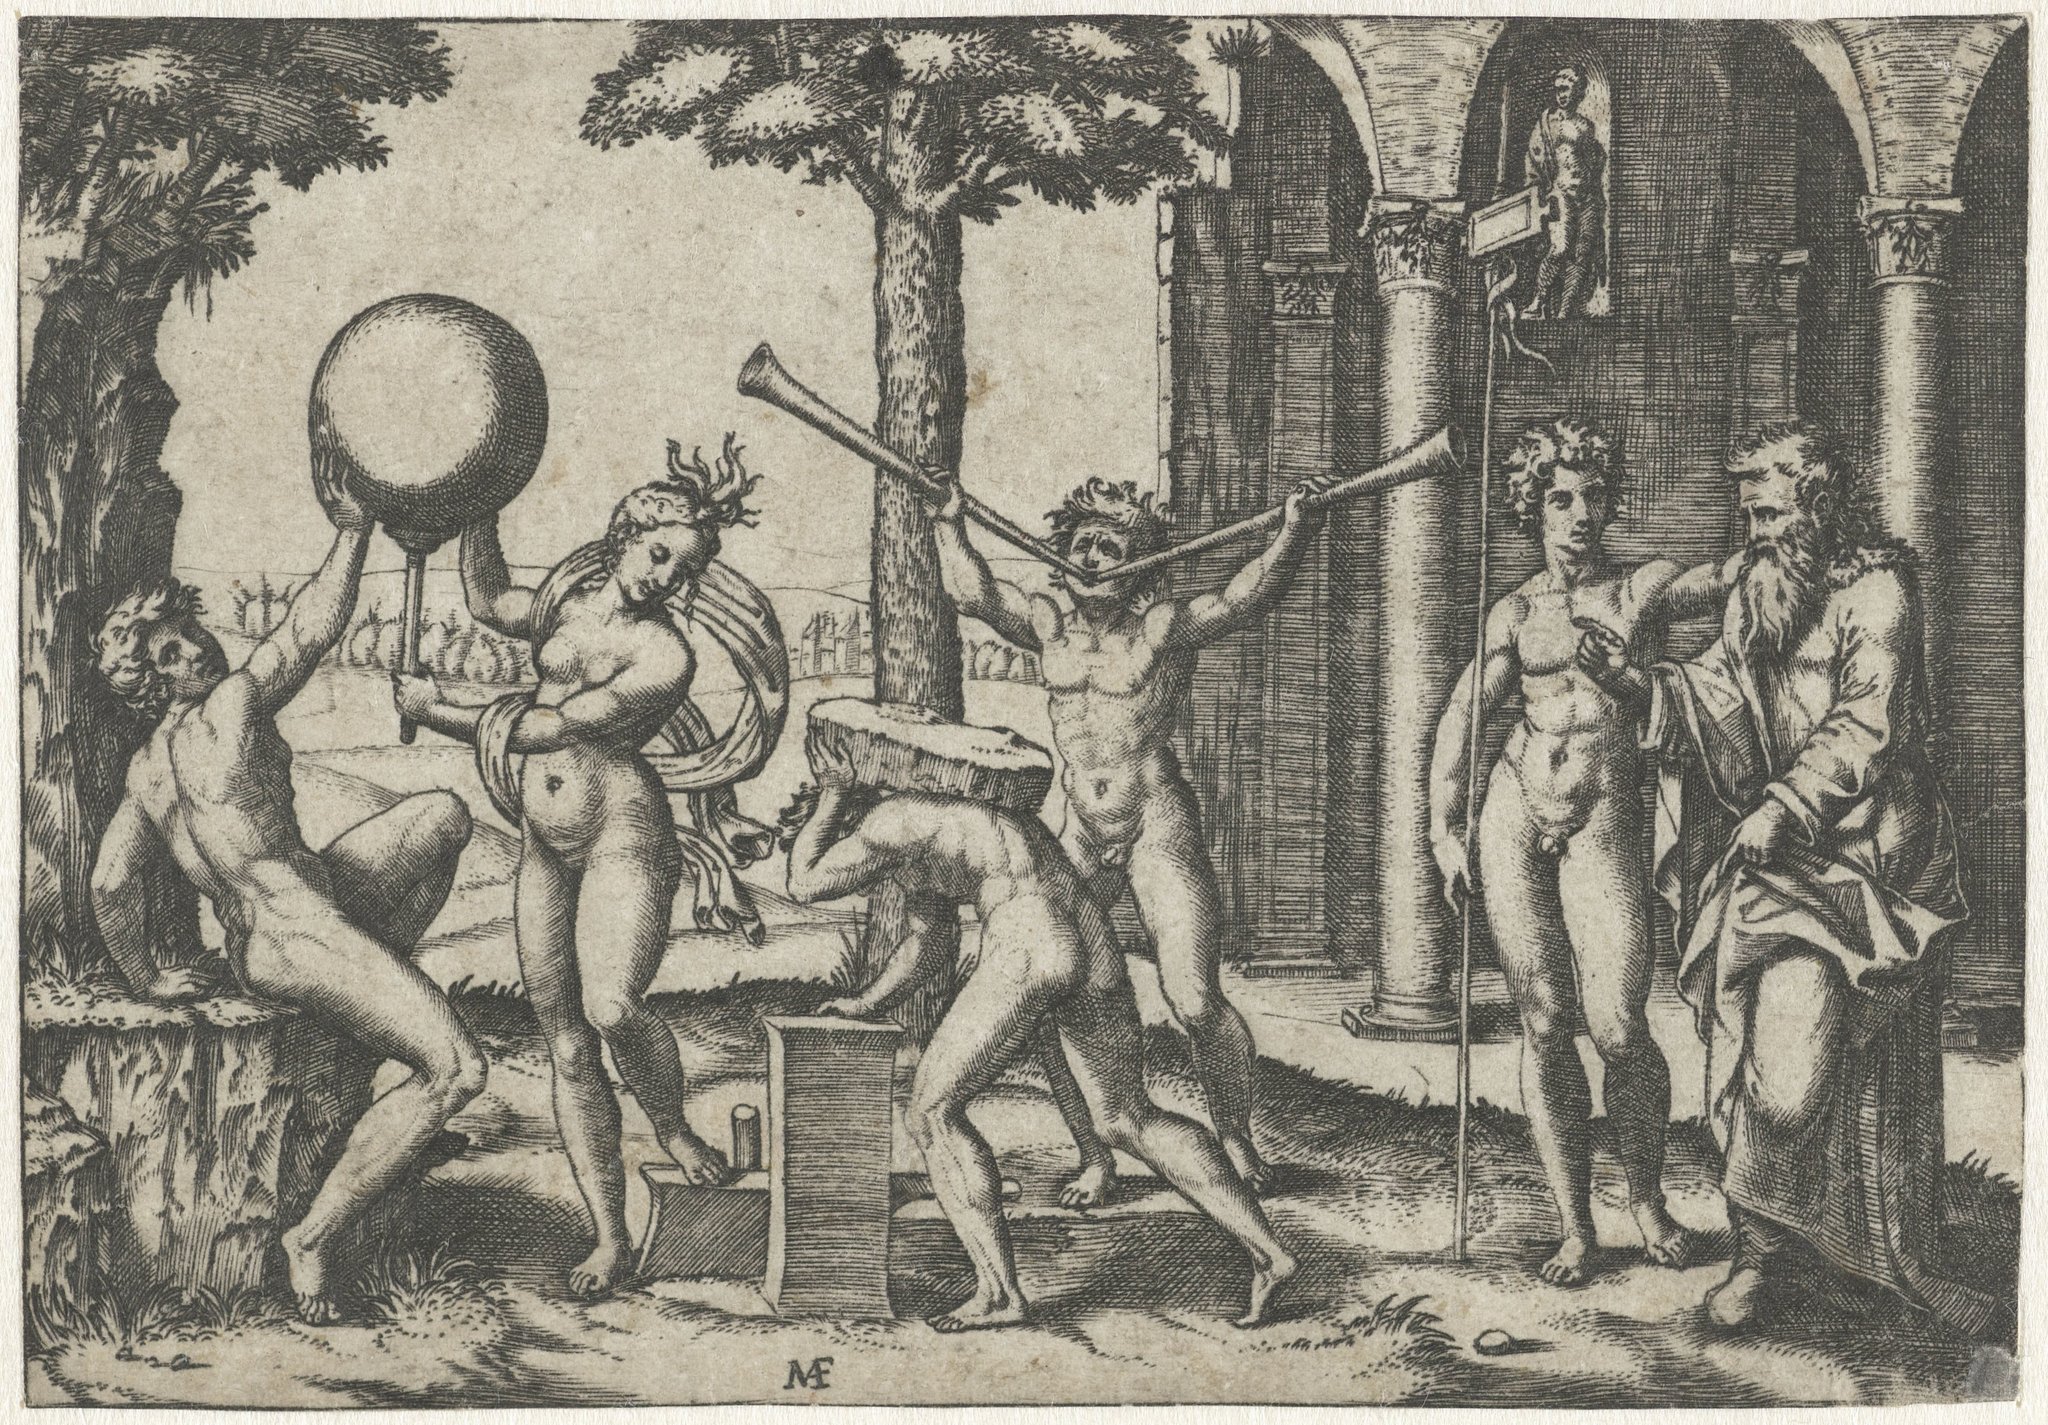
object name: print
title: Man met twee trompetten en man met steen op zijn rug geflankeerd door man en vrouw met globe en oude en jonge man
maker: marcantonio raimondi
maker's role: print maker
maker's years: 1470-1534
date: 1510-1527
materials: paper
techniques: engraving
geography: italy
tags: horn, trumpet, cornet, trombone, tuba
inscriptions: collector's mark: Lugt 240